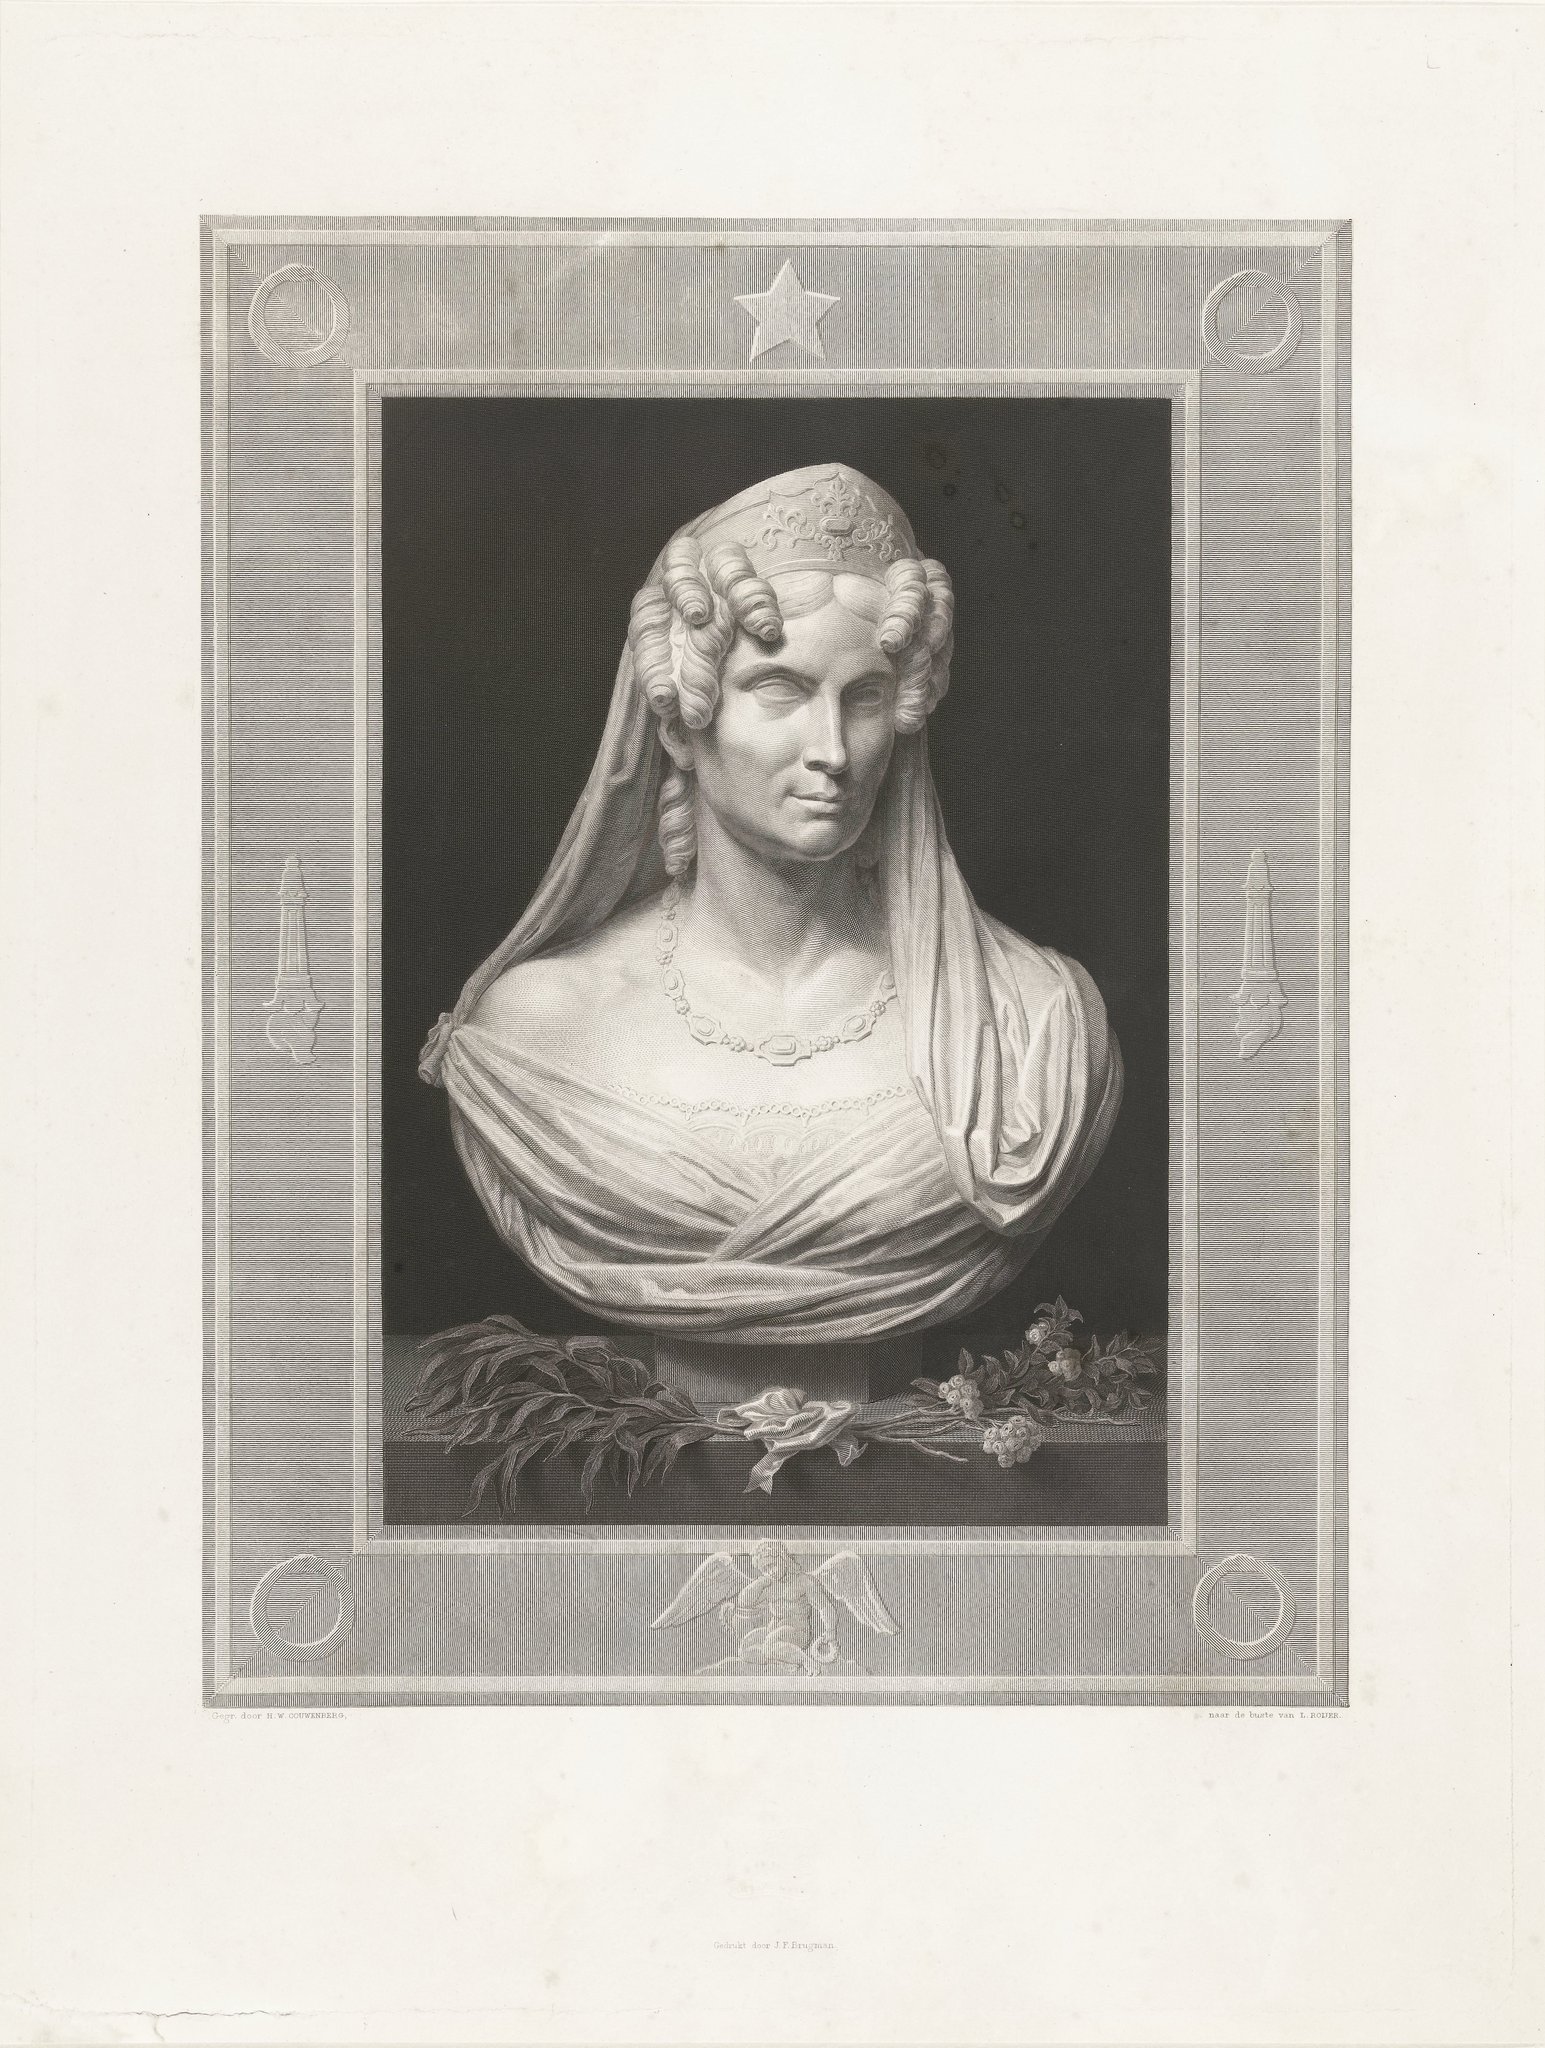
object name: print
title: Portretbuste van Anna Poulowna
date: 1838-1840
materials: paper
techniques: engraving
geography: amsterdam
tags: berlin, the hague, wilhelmina frederica louisa (koningin der nederlanden), piece of sculpture, reproduction of a piece of sculpture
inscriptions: check stamp: ‘Maatsch tot Bev van Beeld Kunsten’, collector's mark: Lugt 2228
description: Twee ontwerptekeningen voor de prent aanwezig in de collectie, inv.nr. RP-T-1912-22, RP-T-1912-21. De marmeren buste van Louis Royer bevindt zich in de Koninklijke Verzamelingen, Den Haag; https://koninklijkeverzamelingen.nl/collectie-online/objects/24501